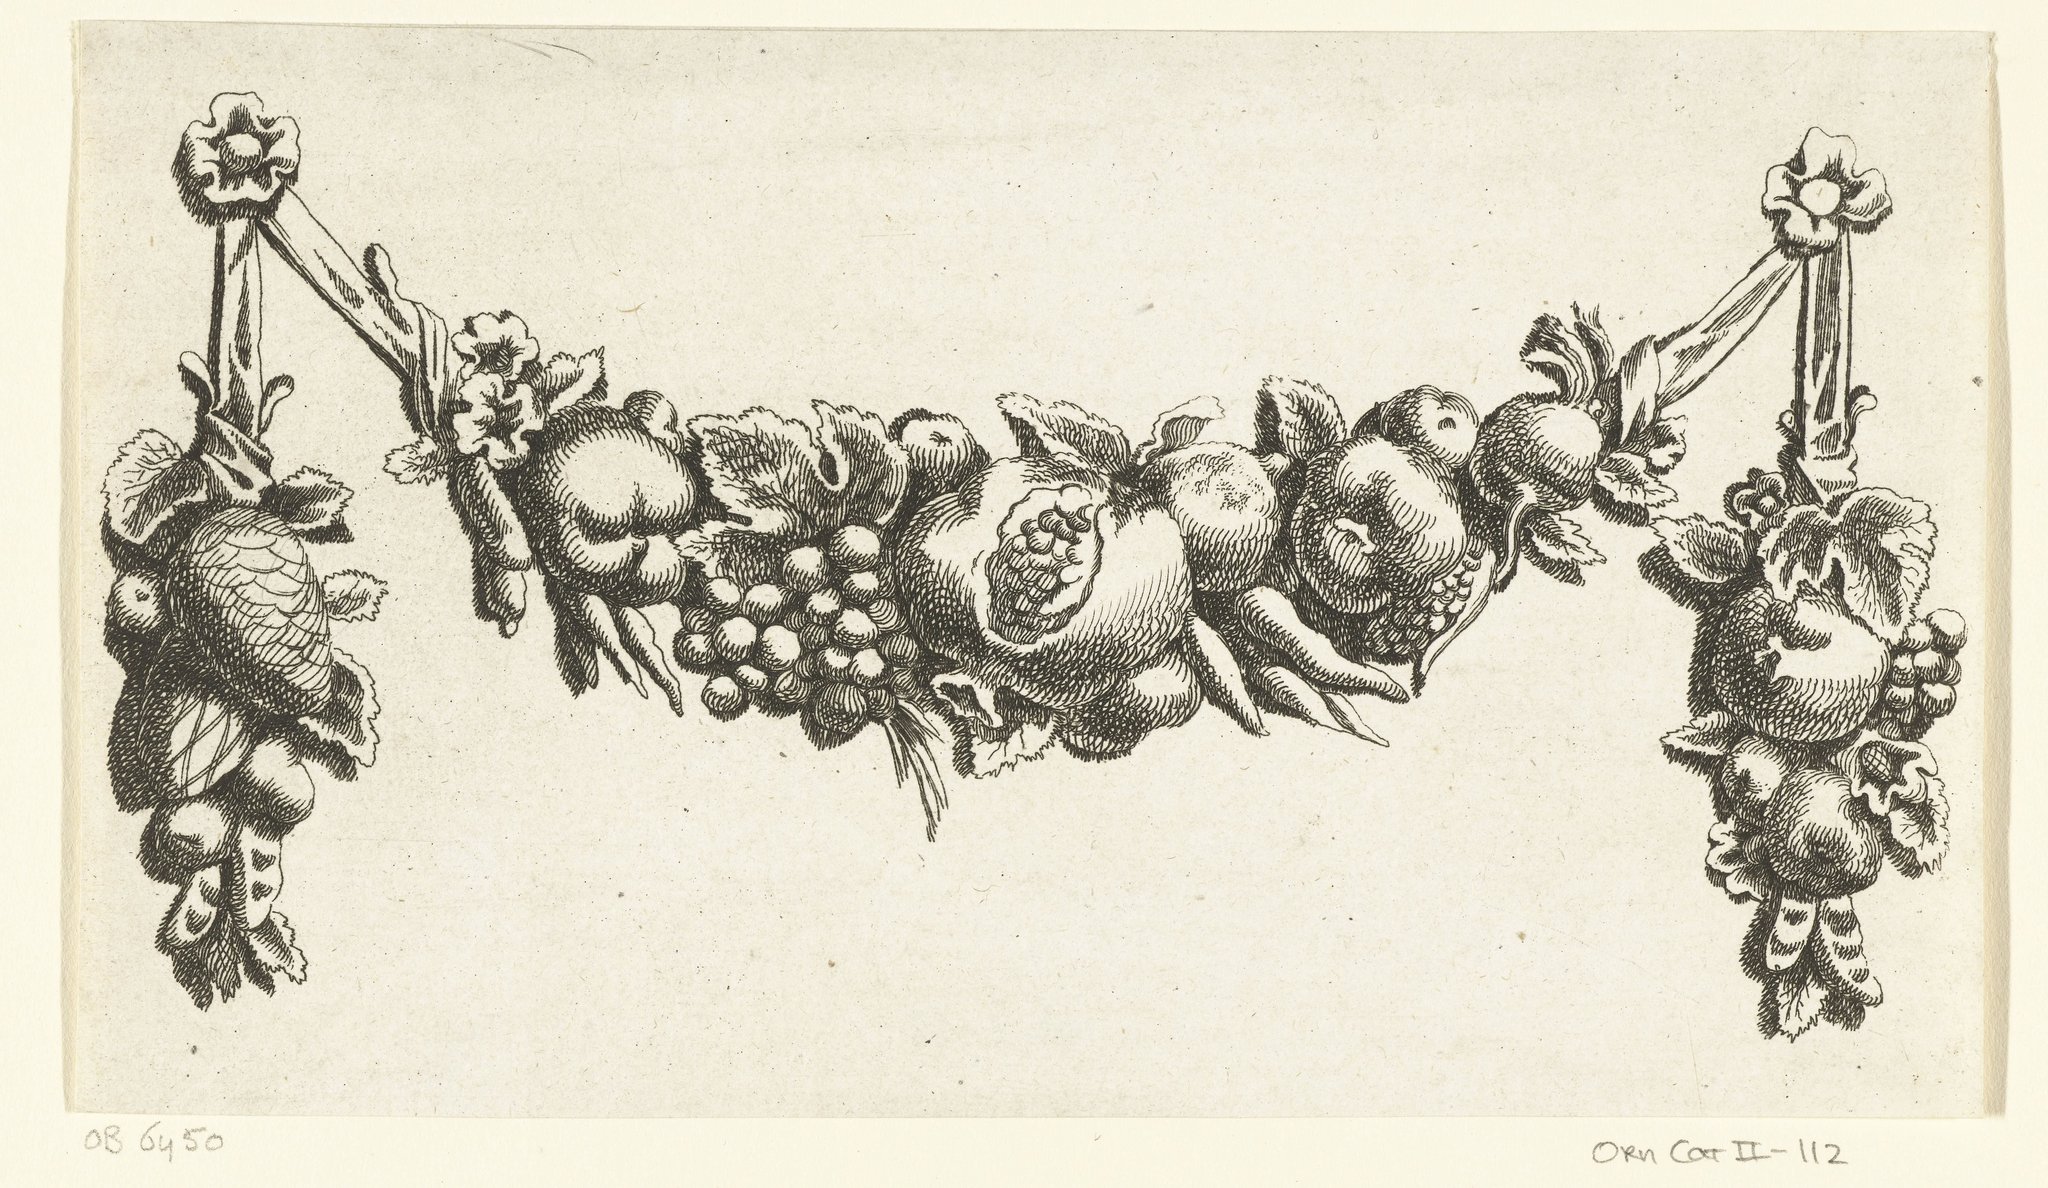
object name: print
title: Festoen met een opengebarsten granaatappel in het midden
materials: paper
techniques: etching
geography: amsterdam